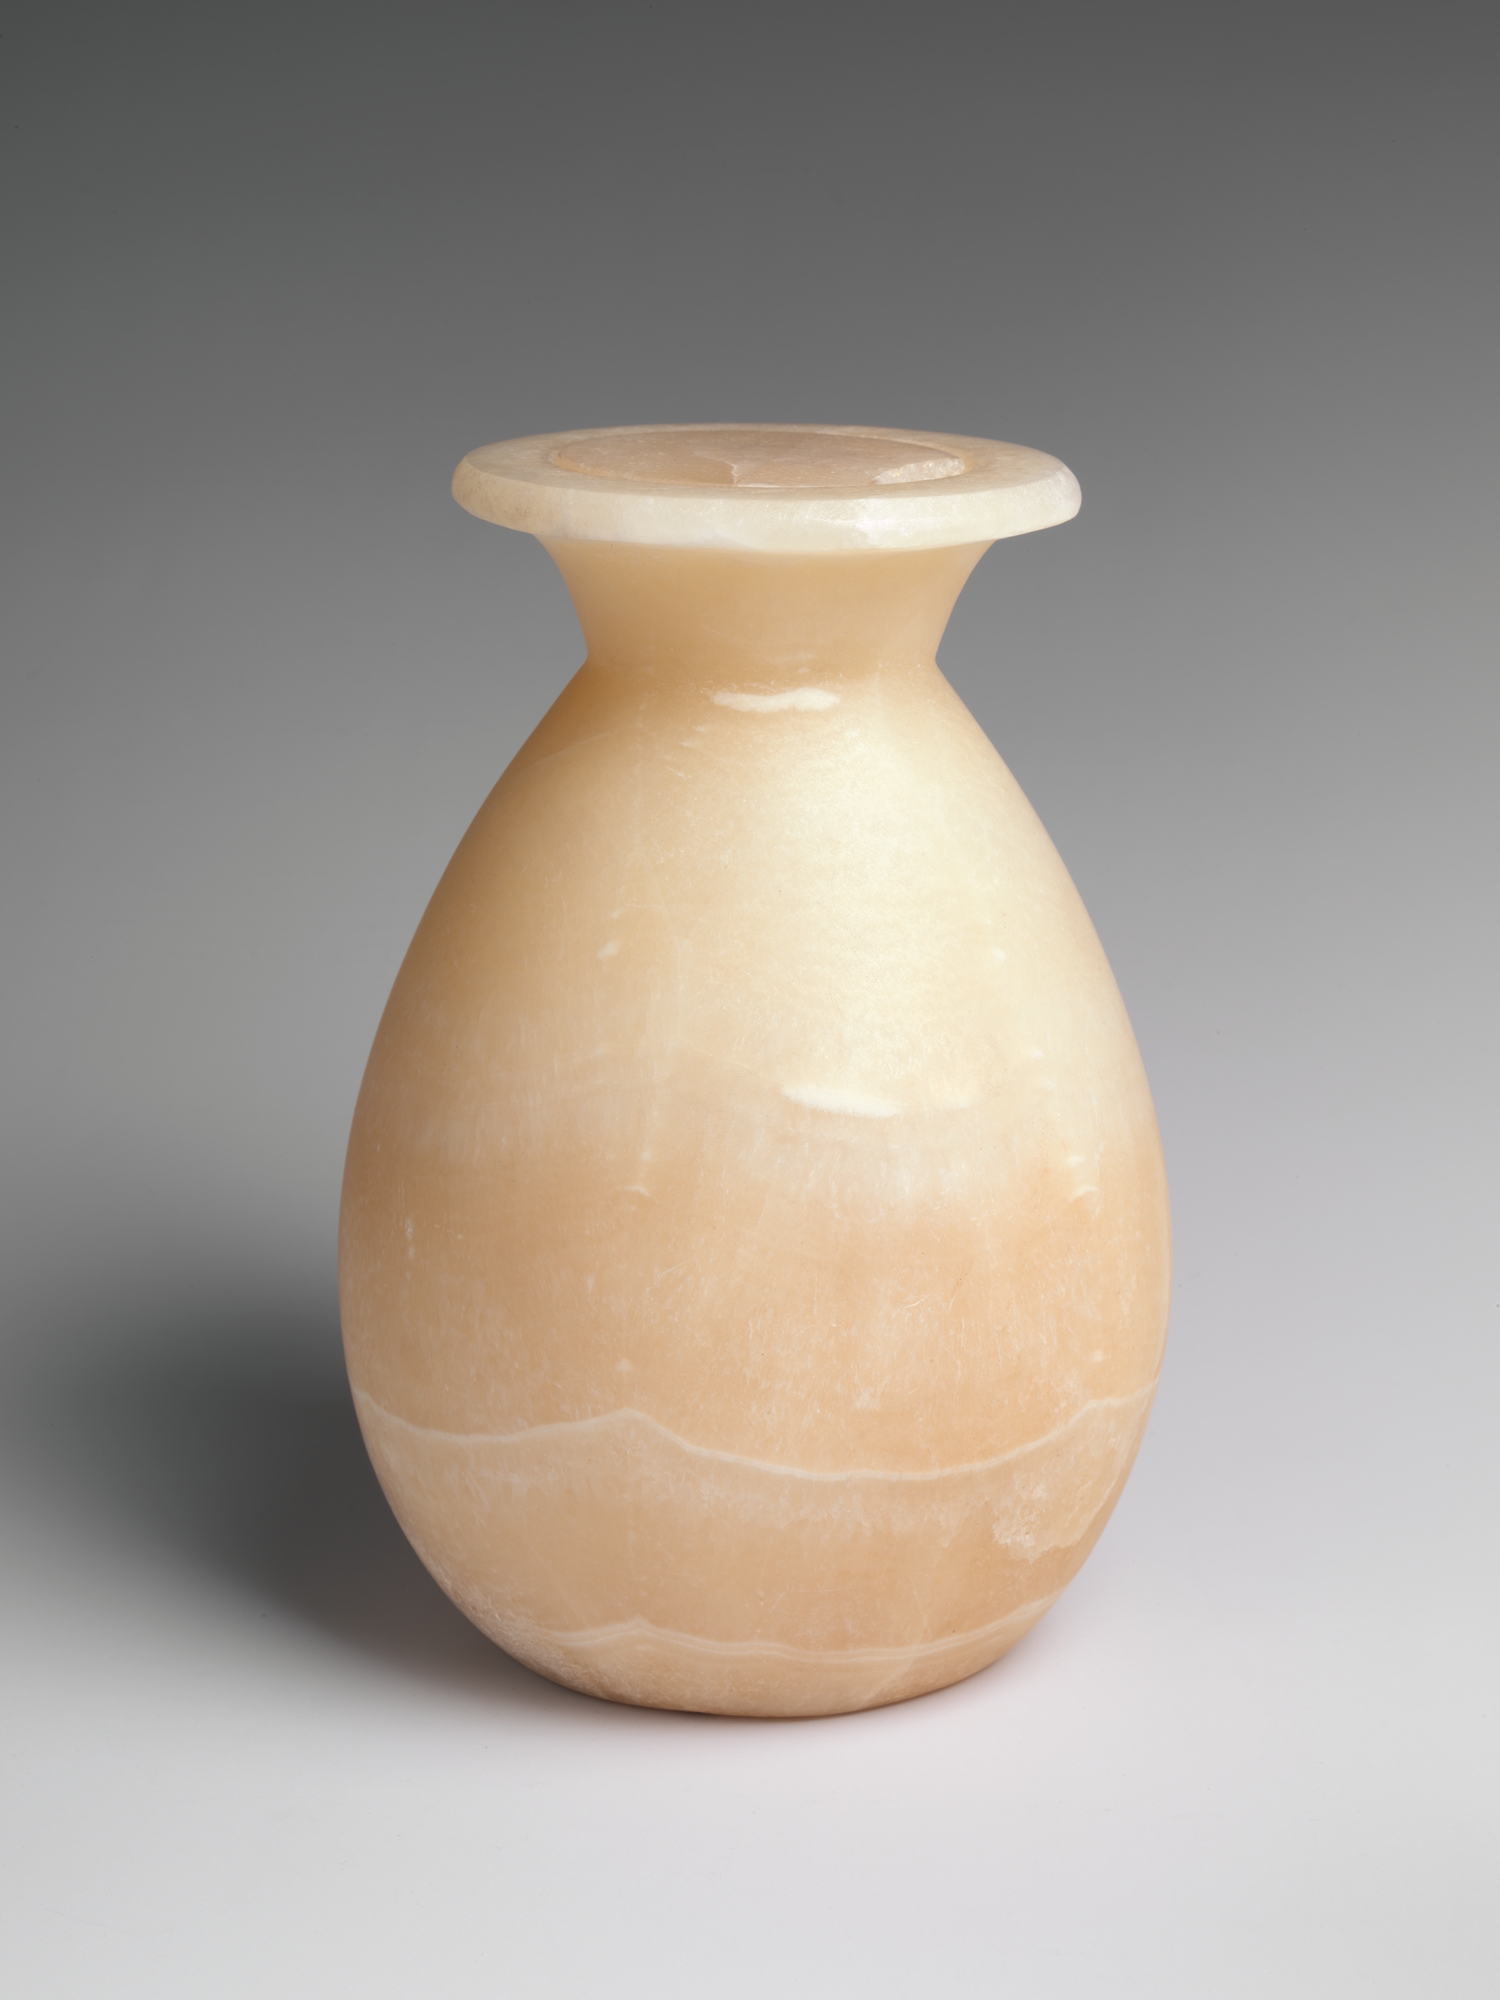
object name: jar, piriform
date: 1550-1458 BCE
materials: stone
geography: egypt